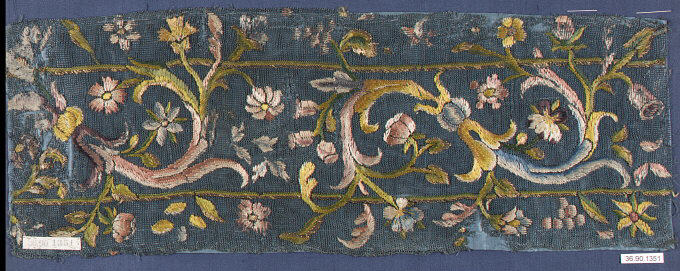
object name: piece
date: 1501-1600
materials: textile, metal thread, silk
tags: flowers,leaves